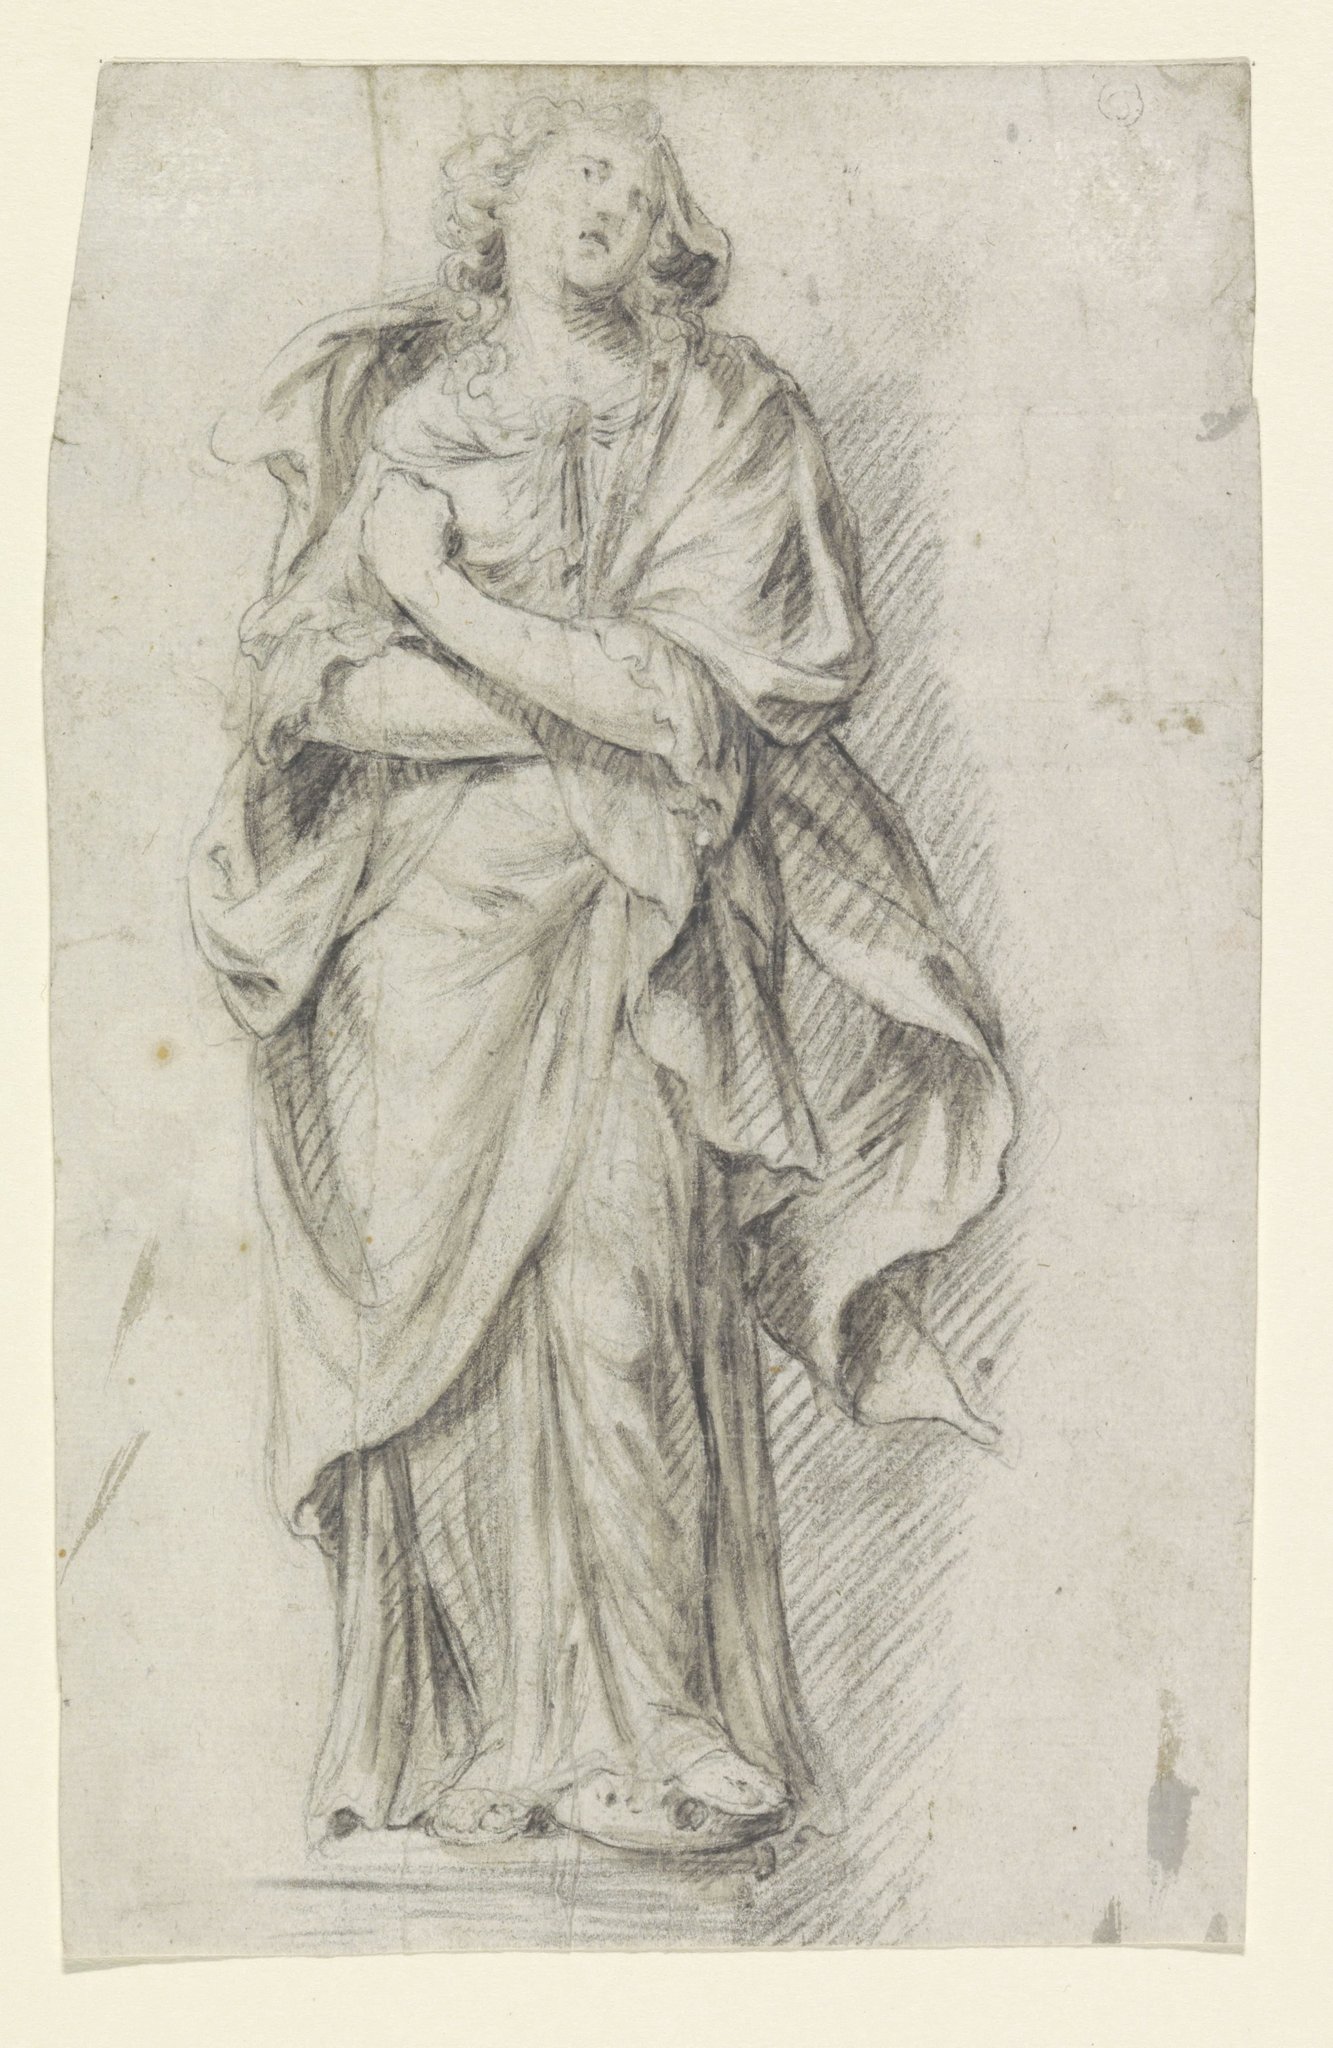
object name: drawing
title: Vrouwelijke heilige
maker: Anonymous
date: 1600-1800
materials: chalk, ink, paper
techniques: brush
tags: female saints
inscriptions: collector's mark: Lugt 2228